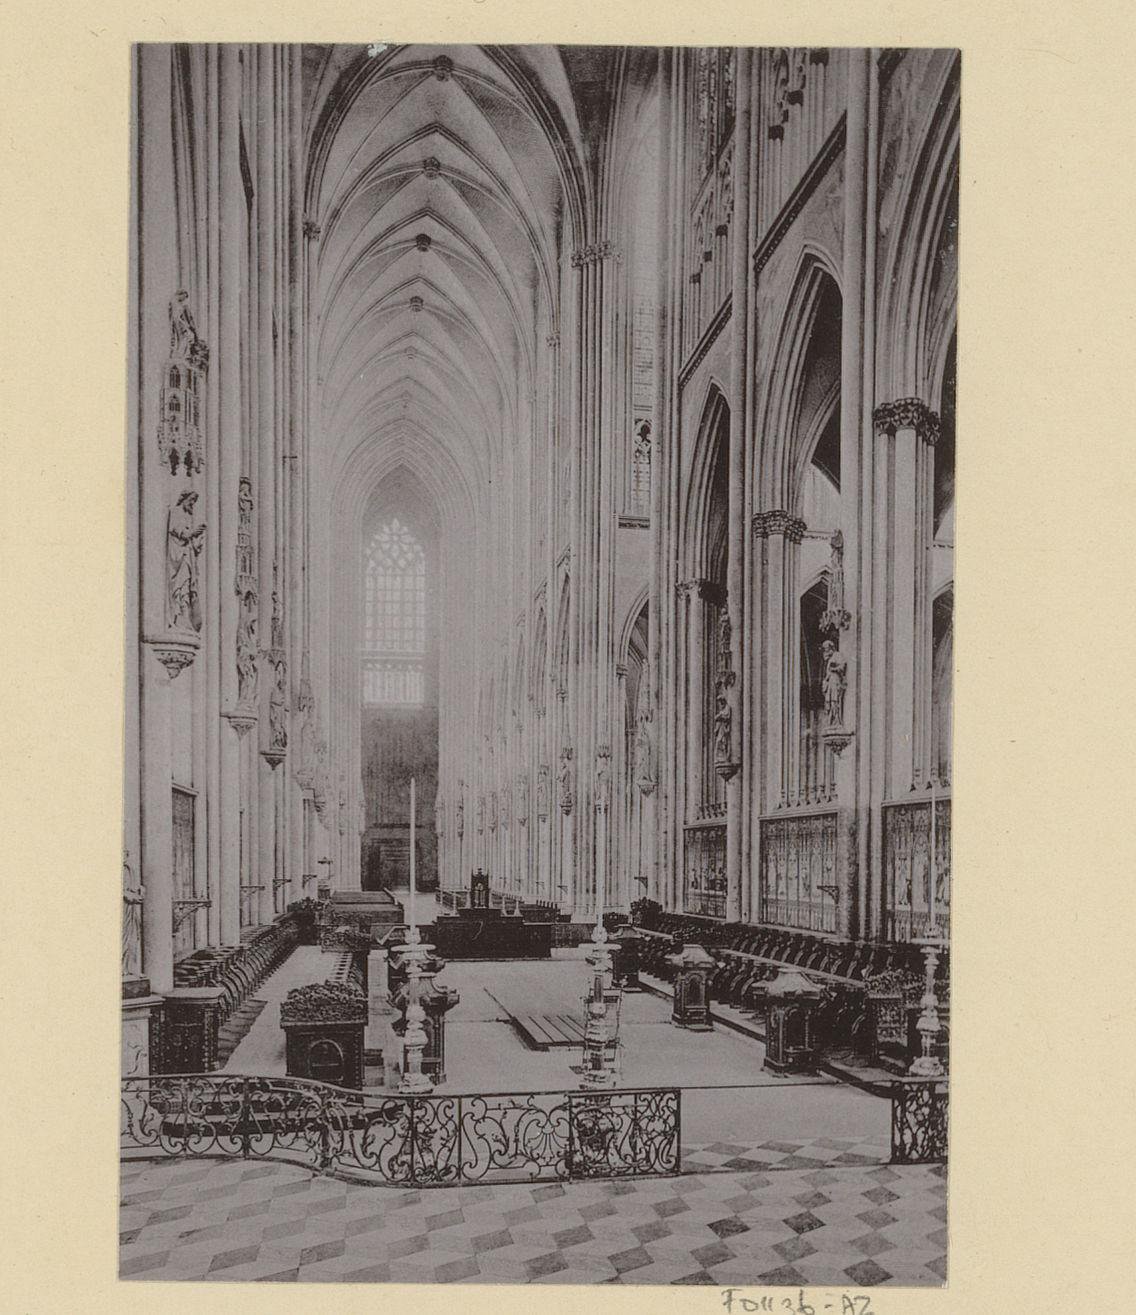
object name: photomechanical print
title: Middenschip van de Dom van Keulen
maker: Anonymous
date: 1880-1895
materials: paper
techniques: photograph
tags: parts of church interior: nave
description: Onderdeel van Fotoalbum met opnames van bezienswaardigheden in België, Duitsland en Noorwegen.